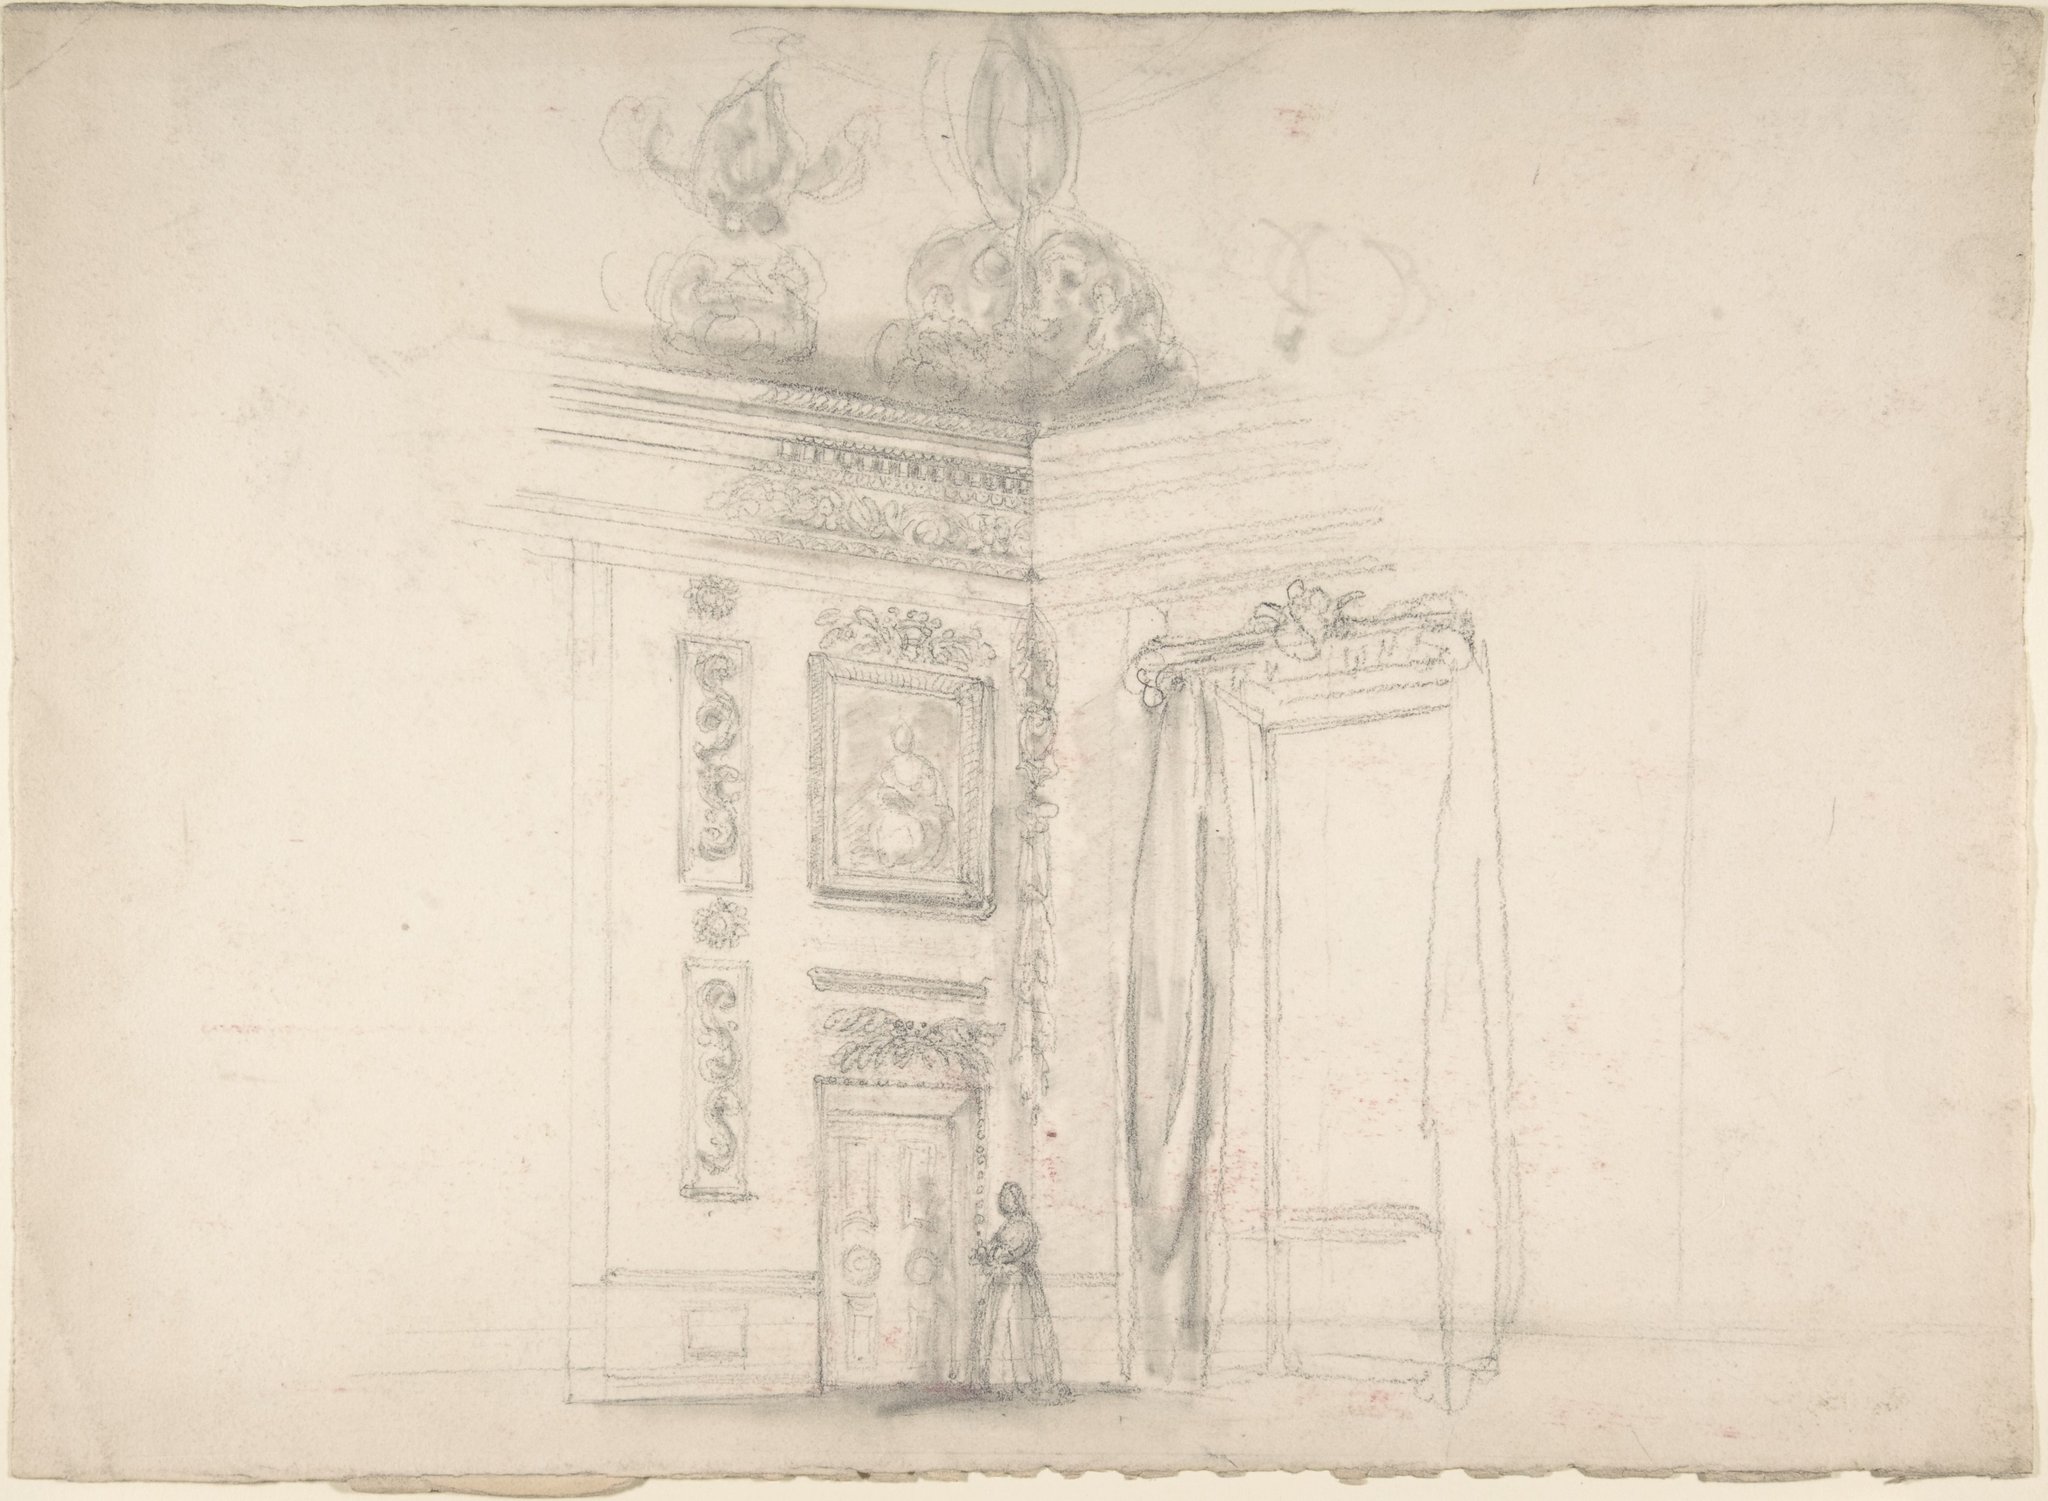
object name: drawing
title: Corner of a Room with a High Coved Ceiling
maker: anonymous, british, 19th century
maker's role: artist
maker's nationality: british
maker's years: 1800-1900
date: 1801-1900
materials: graphite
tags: interiors